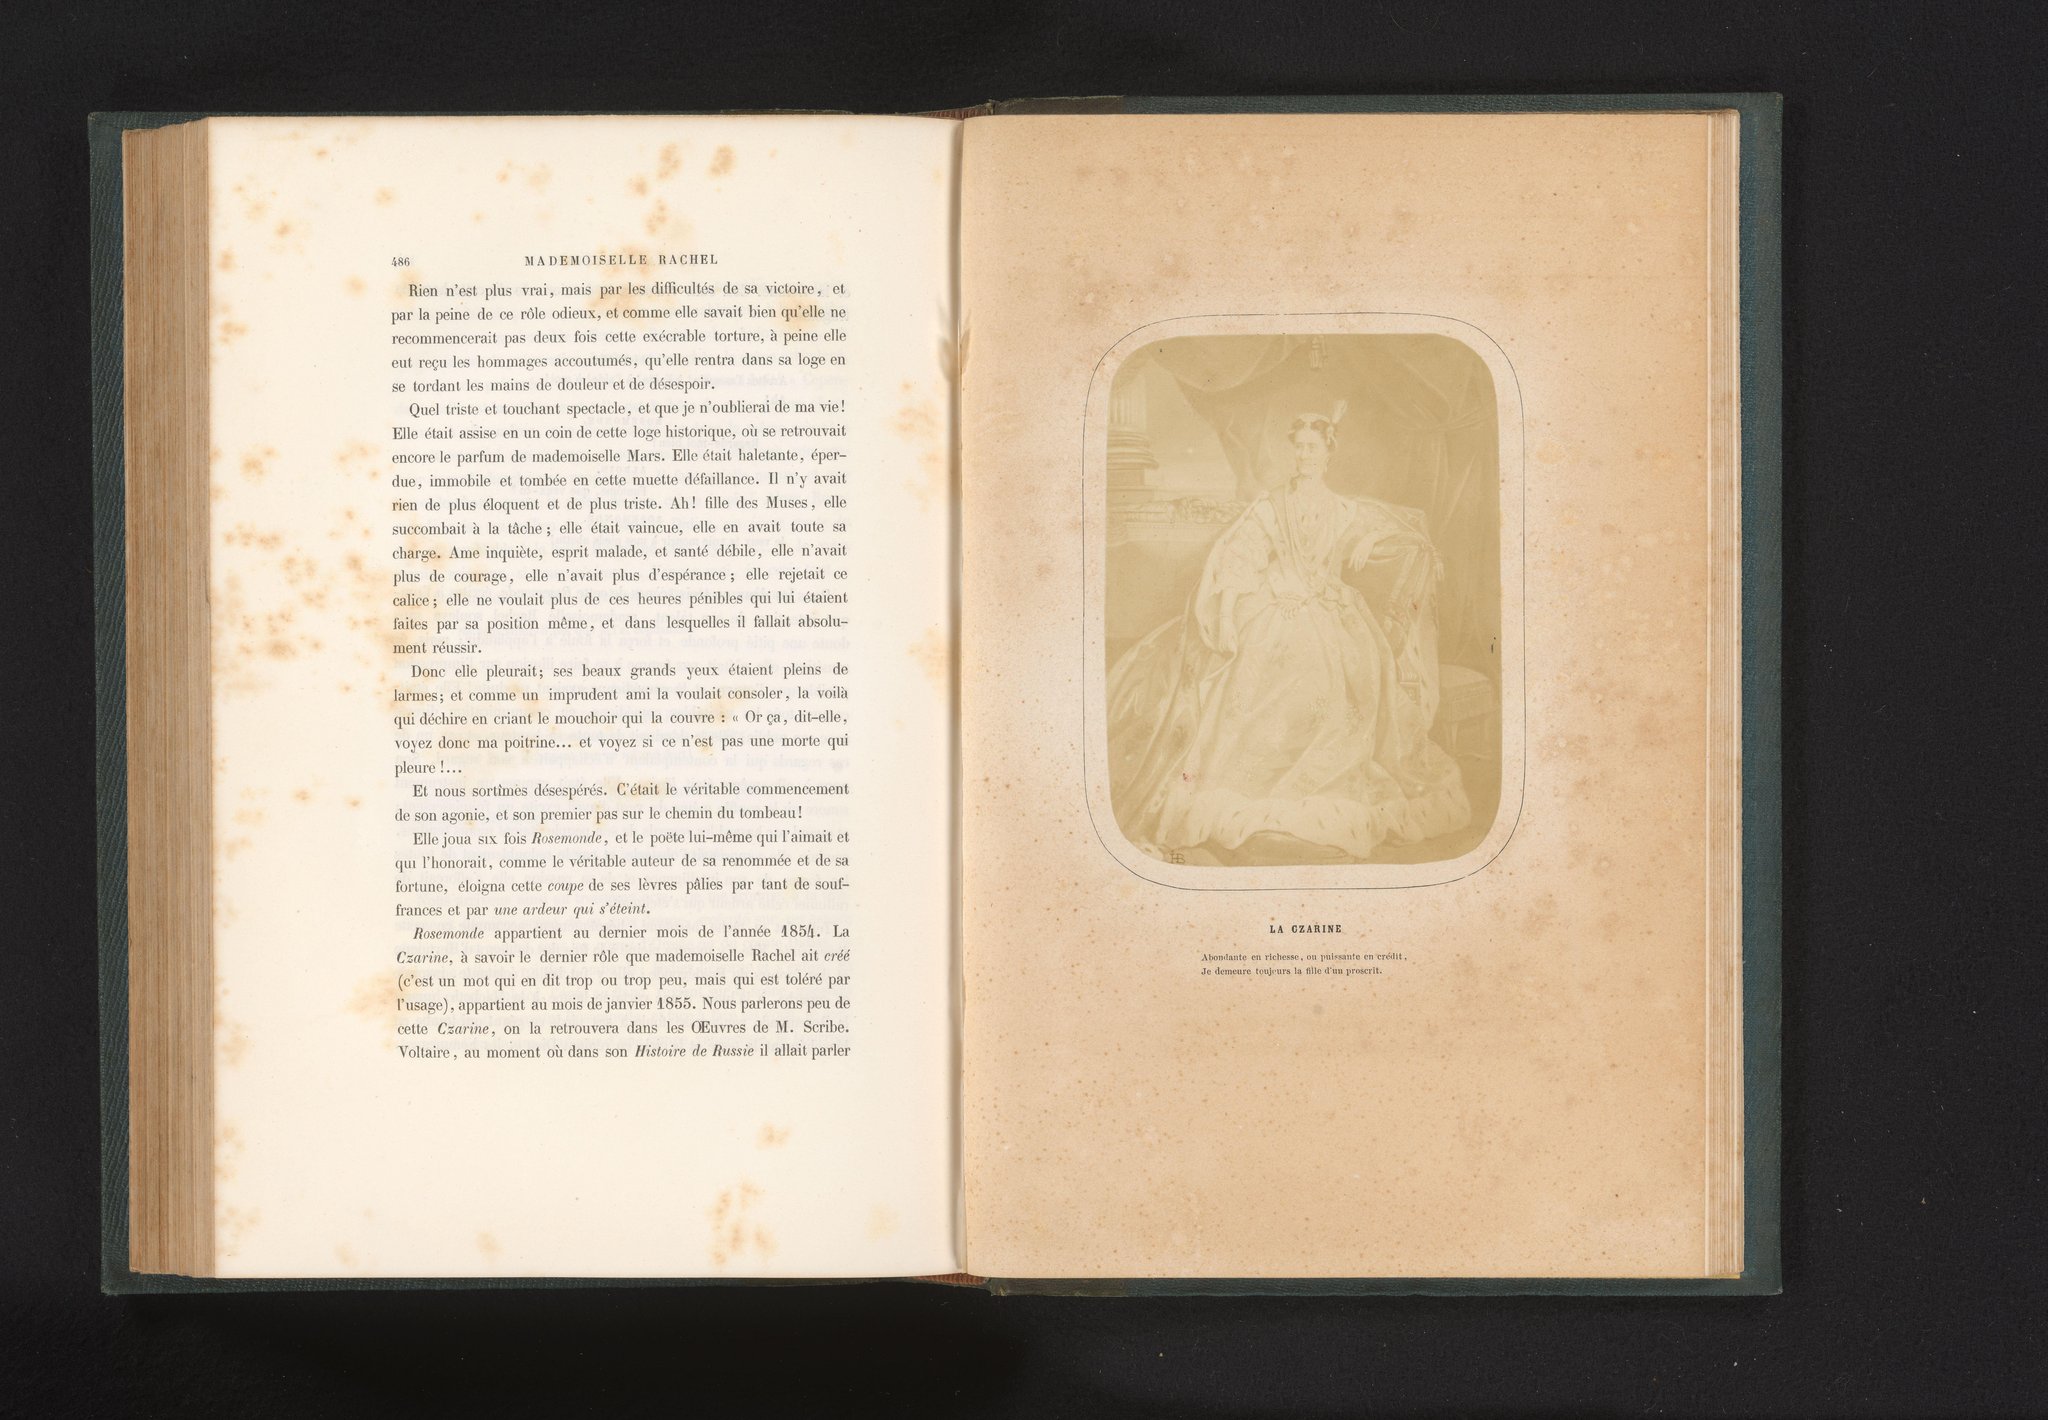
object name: photograph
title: Fotoreproductie van een schilderij met een portret van Elizabeth-Rachel Félix in de rol van La Czarine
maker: henri de la blanchère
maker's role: fotograaf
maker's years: 1821-1880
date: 1850-1859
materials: paper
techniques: albumen print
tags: portrait of actor, actress, picture, painting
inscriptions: inscription: ‘LA CZARINE/ Abondante en richesse, ou puissante en crédit,/ Je demeure toujours la fille d'un proscrit.’, monogram: ‘HB’